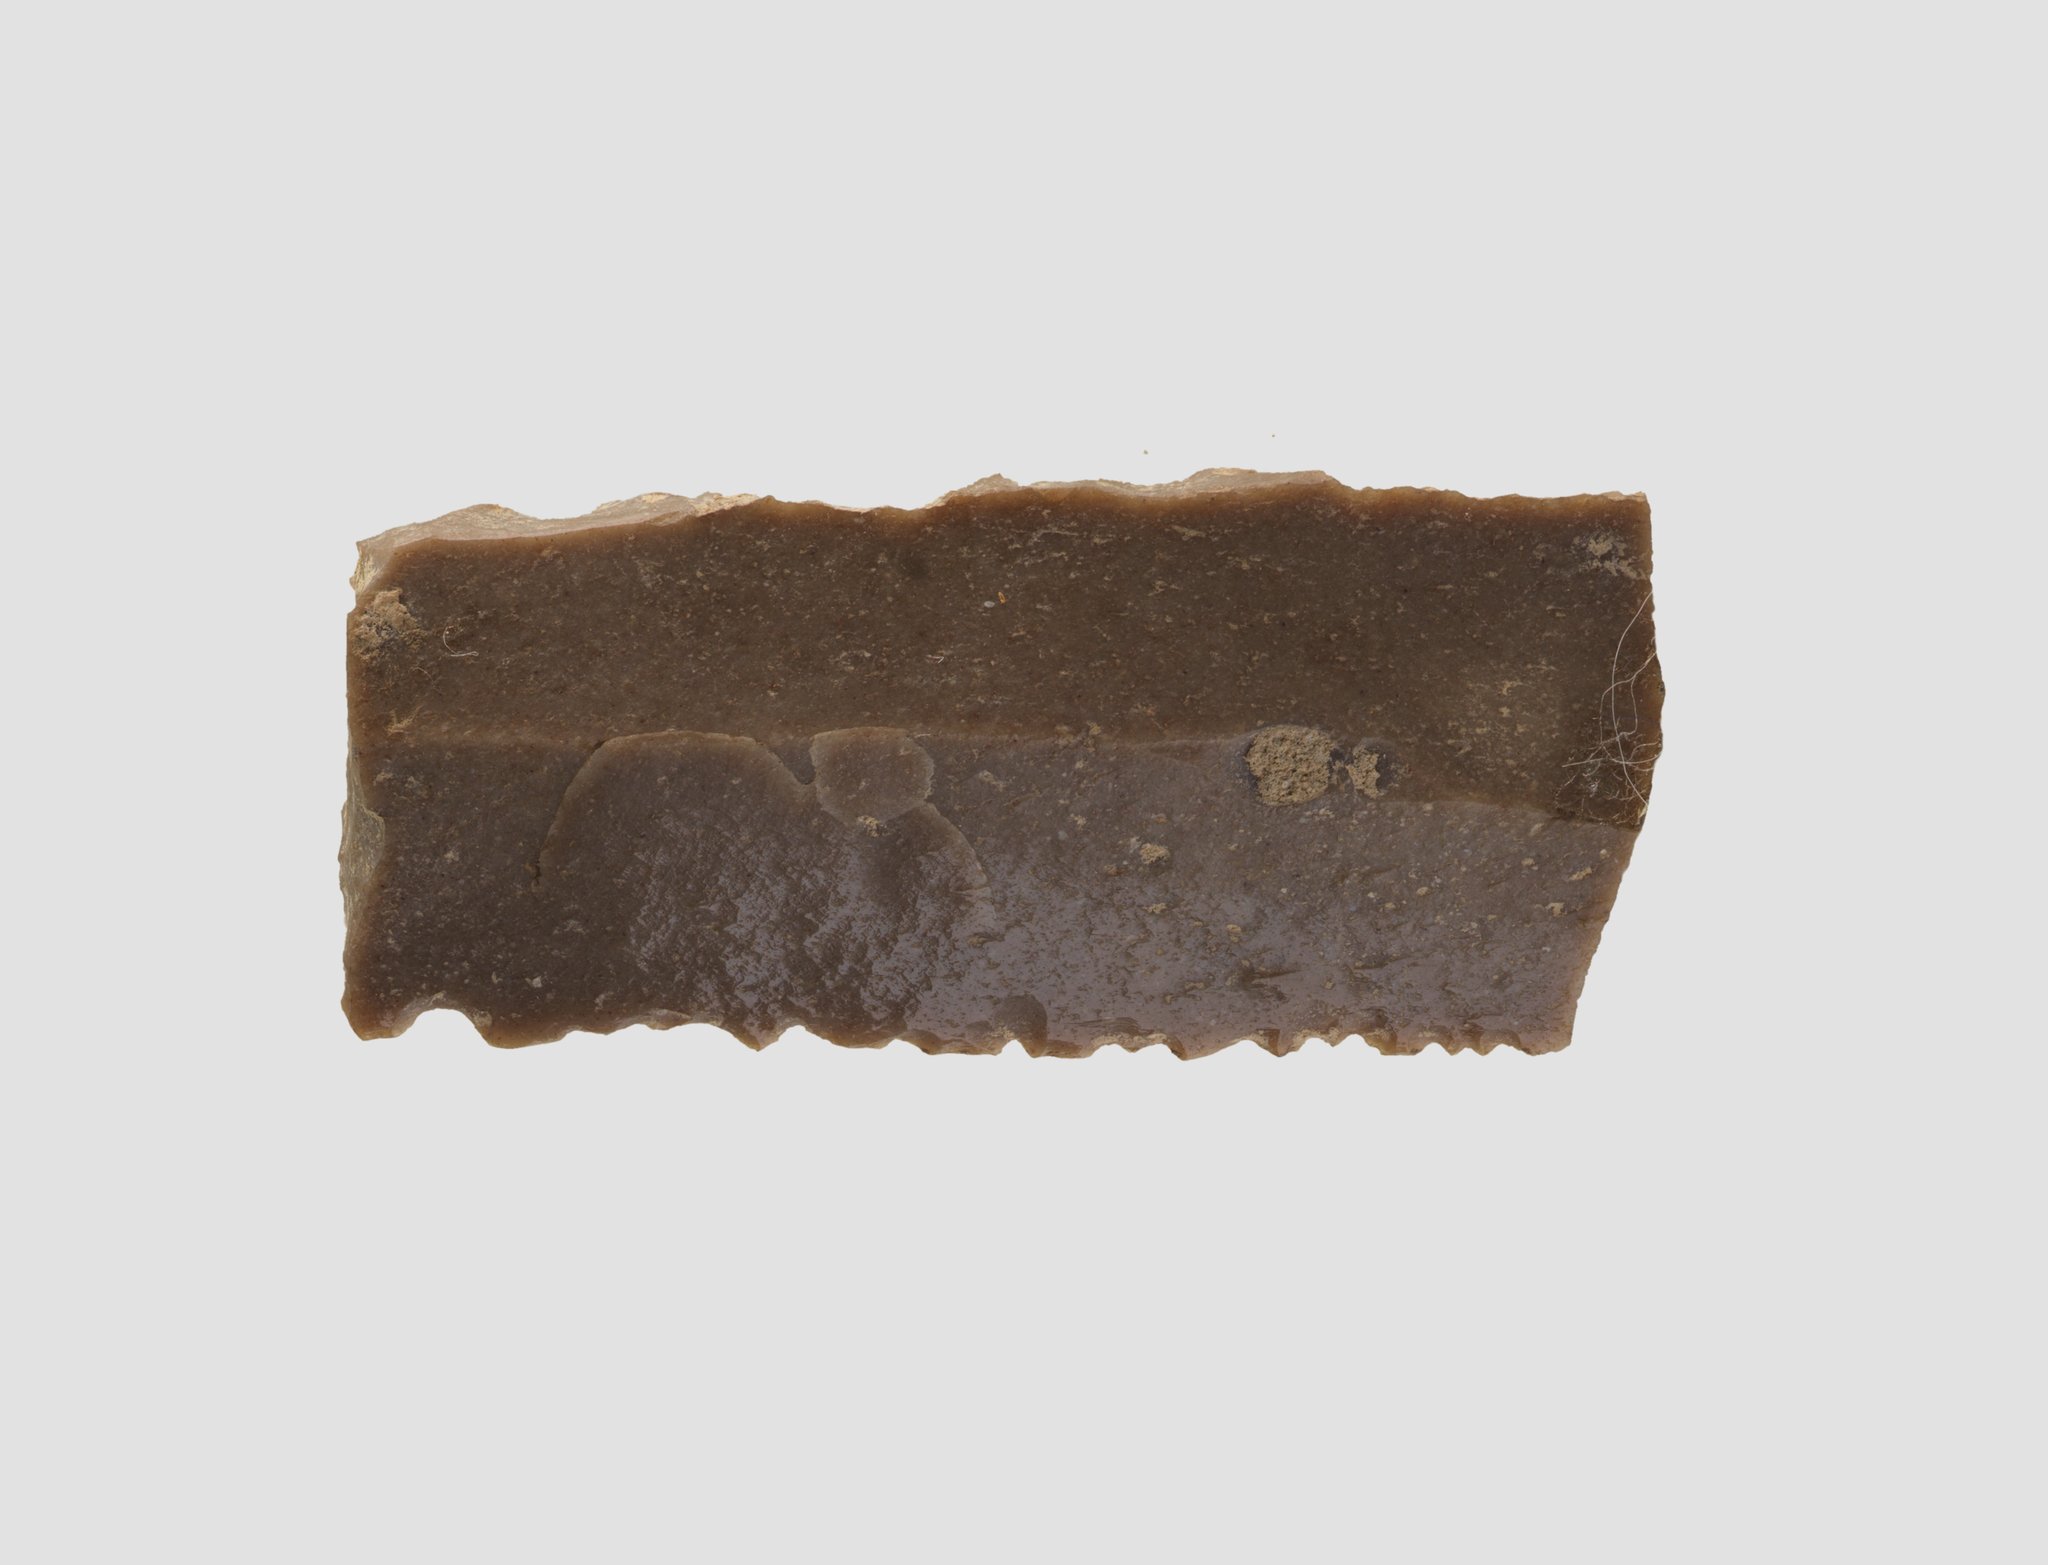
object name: knife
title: Blade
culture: ghassulian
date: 4600-3600 BCE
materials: stone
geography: levant